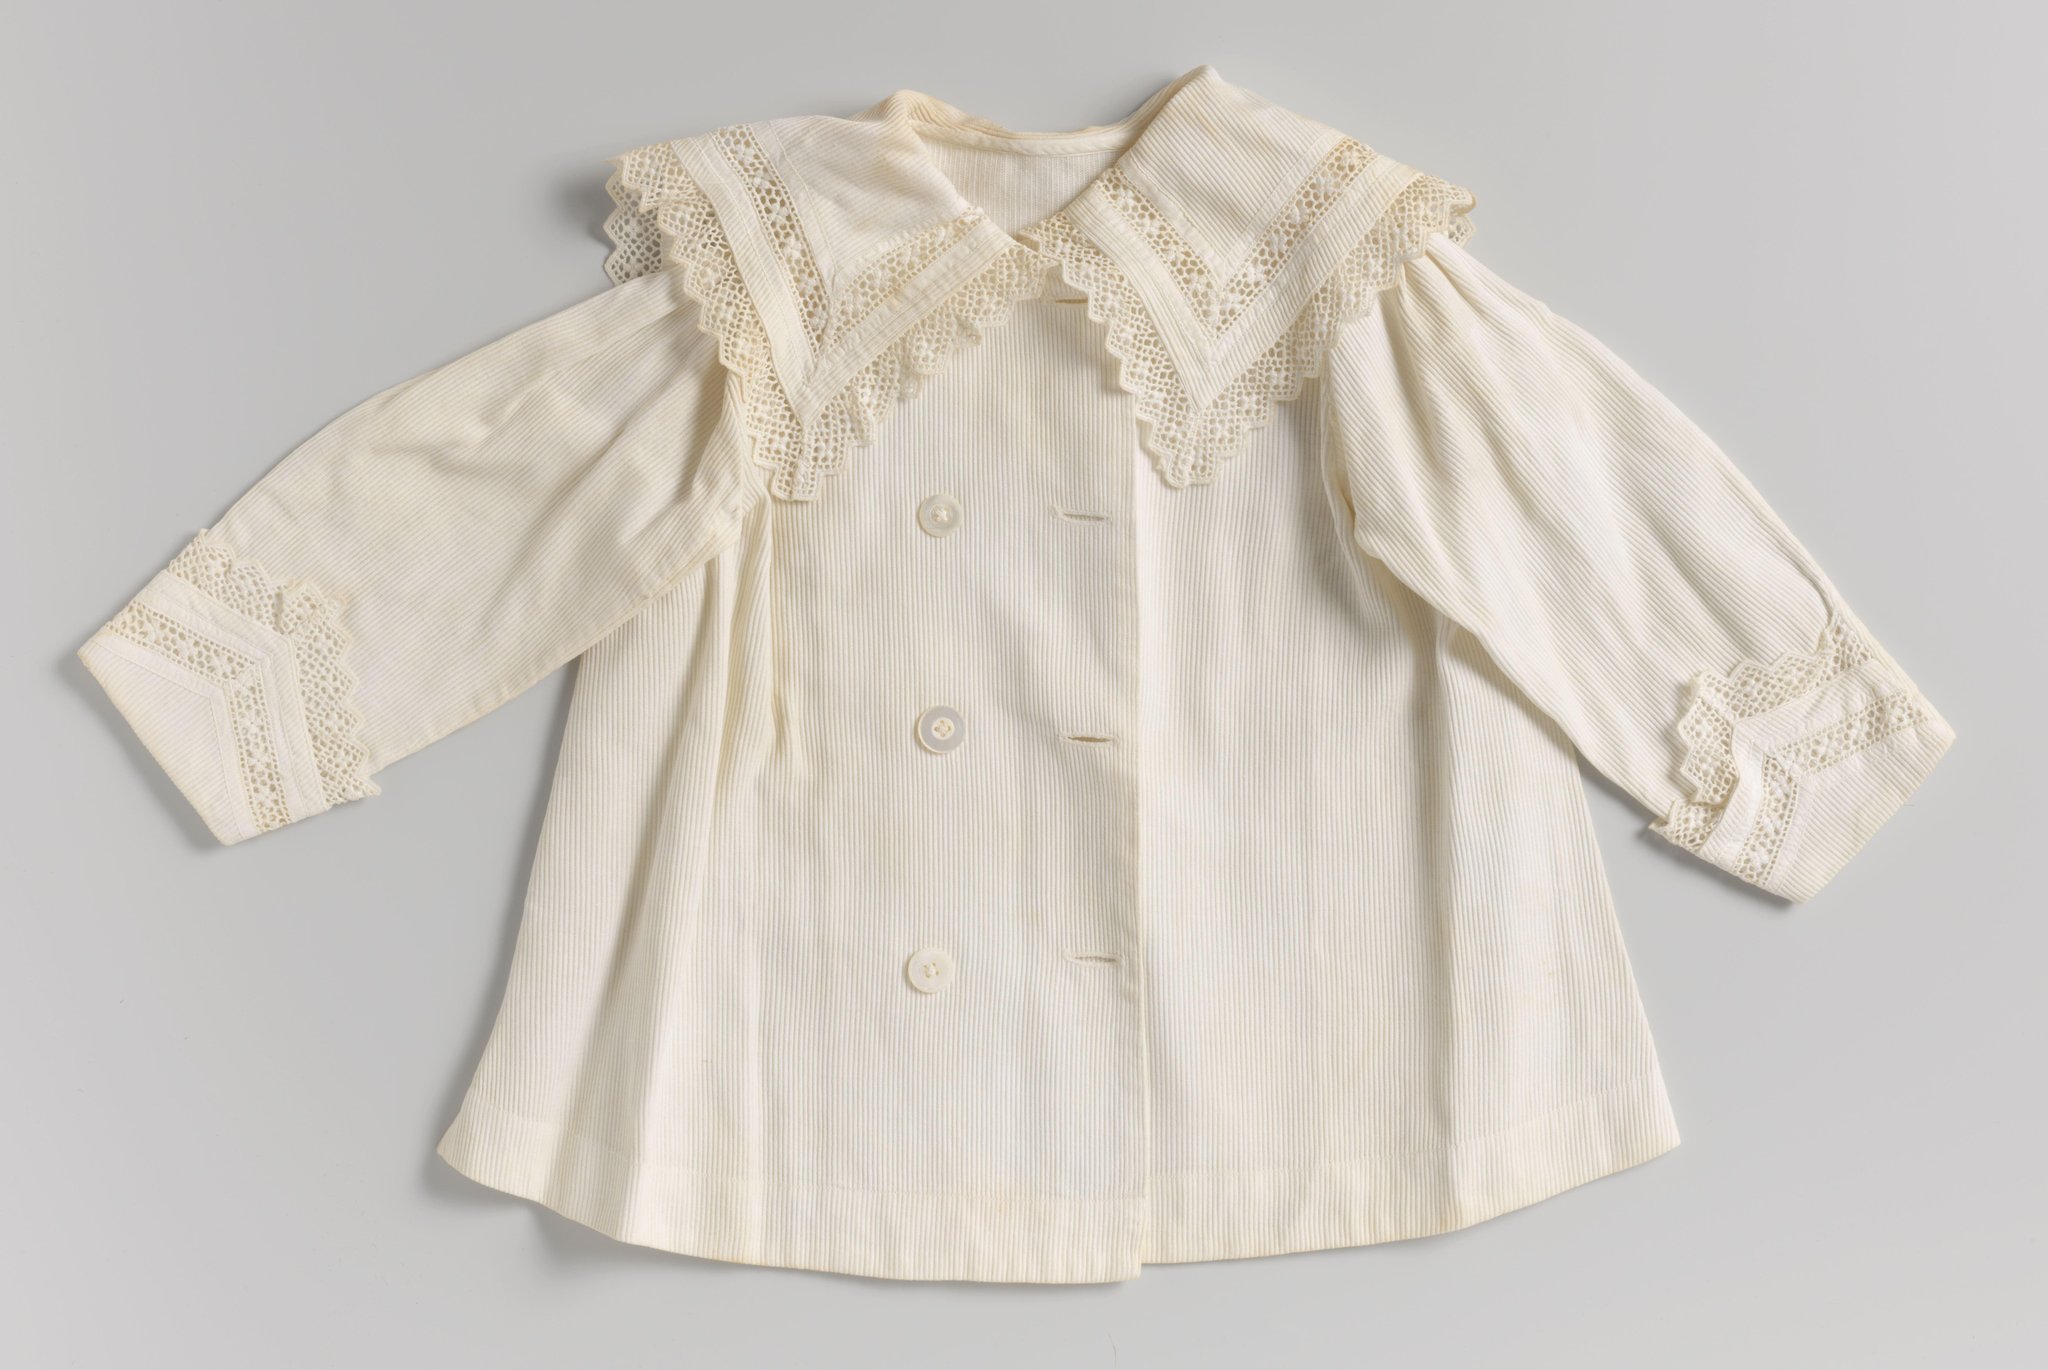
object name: coat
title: Jasje van witte keperkatoen met in de kraag en manchetten tussenzetsels van machinale kant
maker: Anonymous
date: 1905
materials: cotton, linen, mother of pearl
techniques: lace, weave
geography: netherlands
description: Wagenjas van witte keperkatoen met tussenzetsels van machinale kant. Stof: met staande ribbels. Model: gerend. Vierkante matrozenkraag. Lange, iets gepofte mouwen met driehoekige opslag bij de pols. Sluiting oorspronkelijk door middel van twee rijen parelmoeren knopen. Eén rij knopen ontbreekt. De randen van de voorpanden zijn gevoerd met een breed beleg van linnen. Versiering: machinale kant als tussenzetsel en puntstrookjes langs de kraag en de opslagjes.